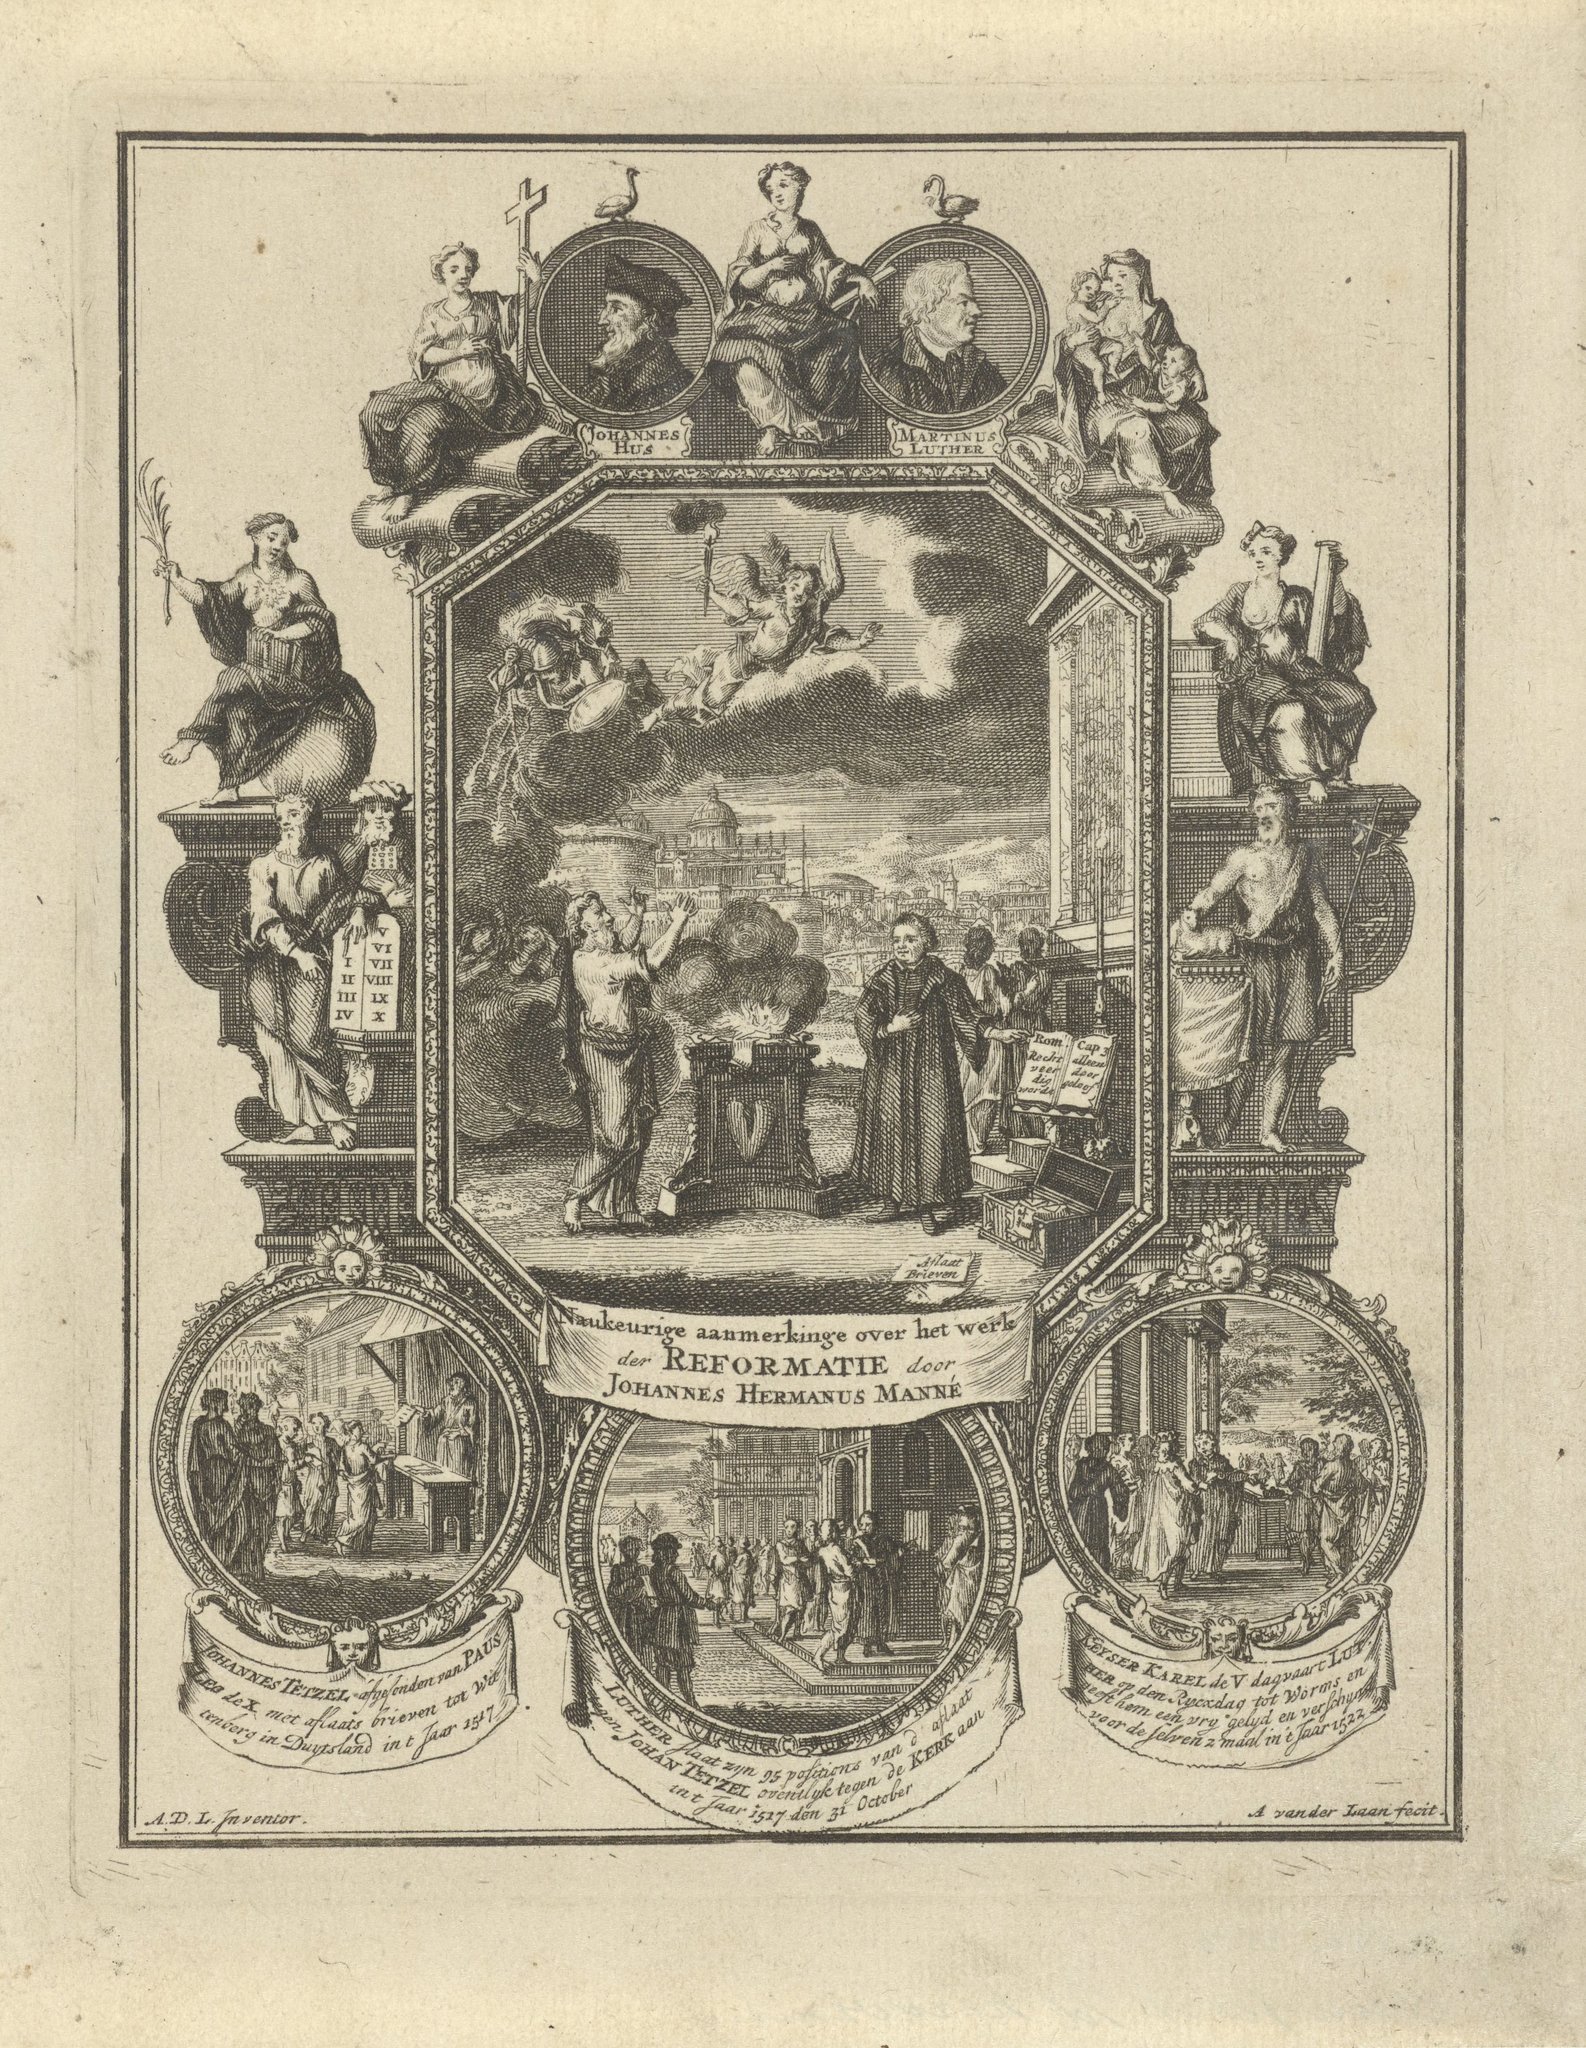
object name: titelblad, titelpagina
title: Titelpagina voor: J. Manné, Nauwkeurige zo theologise als historise aanmerkingen over het werk der reformatie, 1719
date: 1719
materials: paper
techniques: etching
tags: martin luther, 'confessio augustana', 'augsburger konfession', (story of) jupiter (zeus)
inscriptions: collector's mark: Lugt 2228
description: Allegorie op het tweede eeuwfeest van de Hervorming in een architecturale omlijsting, versierd met allegorische figuren en portretmedaillons van Luther en Hus. Allegorische voorstelling met de hervormers Luther en Melanthon bij een altaar, in de verte ligt de Sint Pieterskerk. In de lucht vliegt een engel met brandende toorts, naast haar is Jupiter met bliksemschichten verschenen. Hieronder drie historische voorstellingen in medaillon, voorzien van toelichtende teksten.